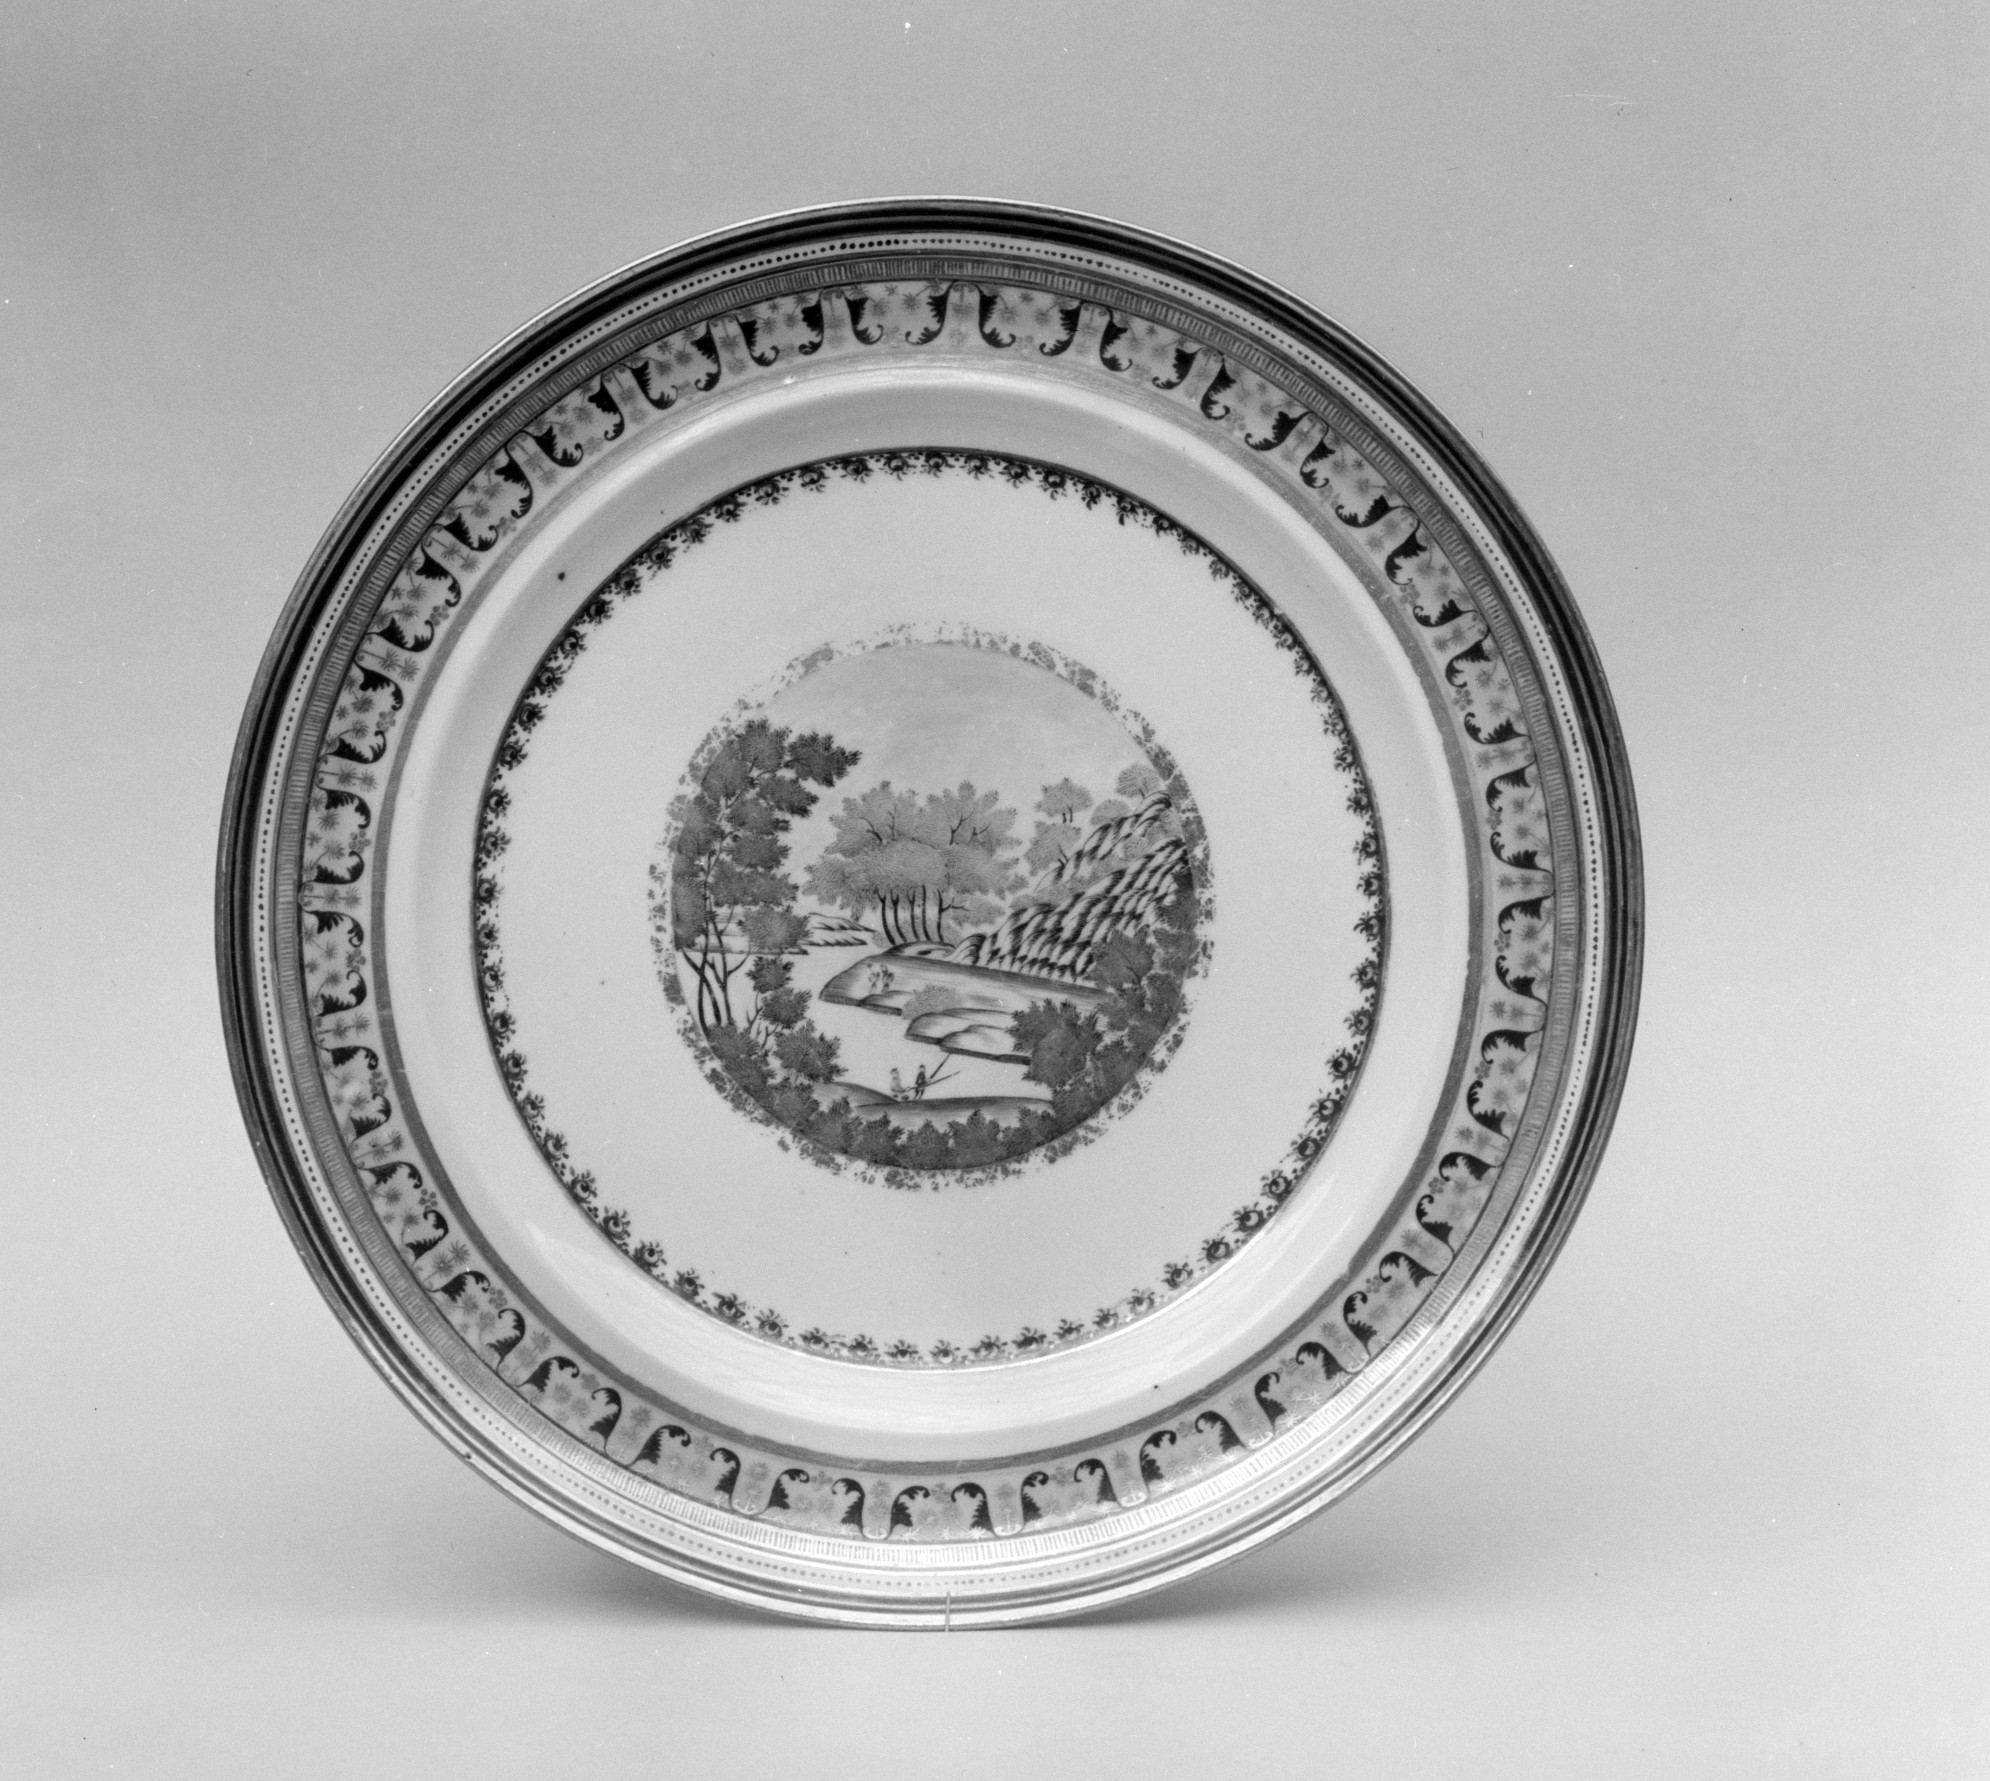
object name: plate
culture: chinese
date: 1800-1830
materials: porcelain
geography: china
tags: landscapes